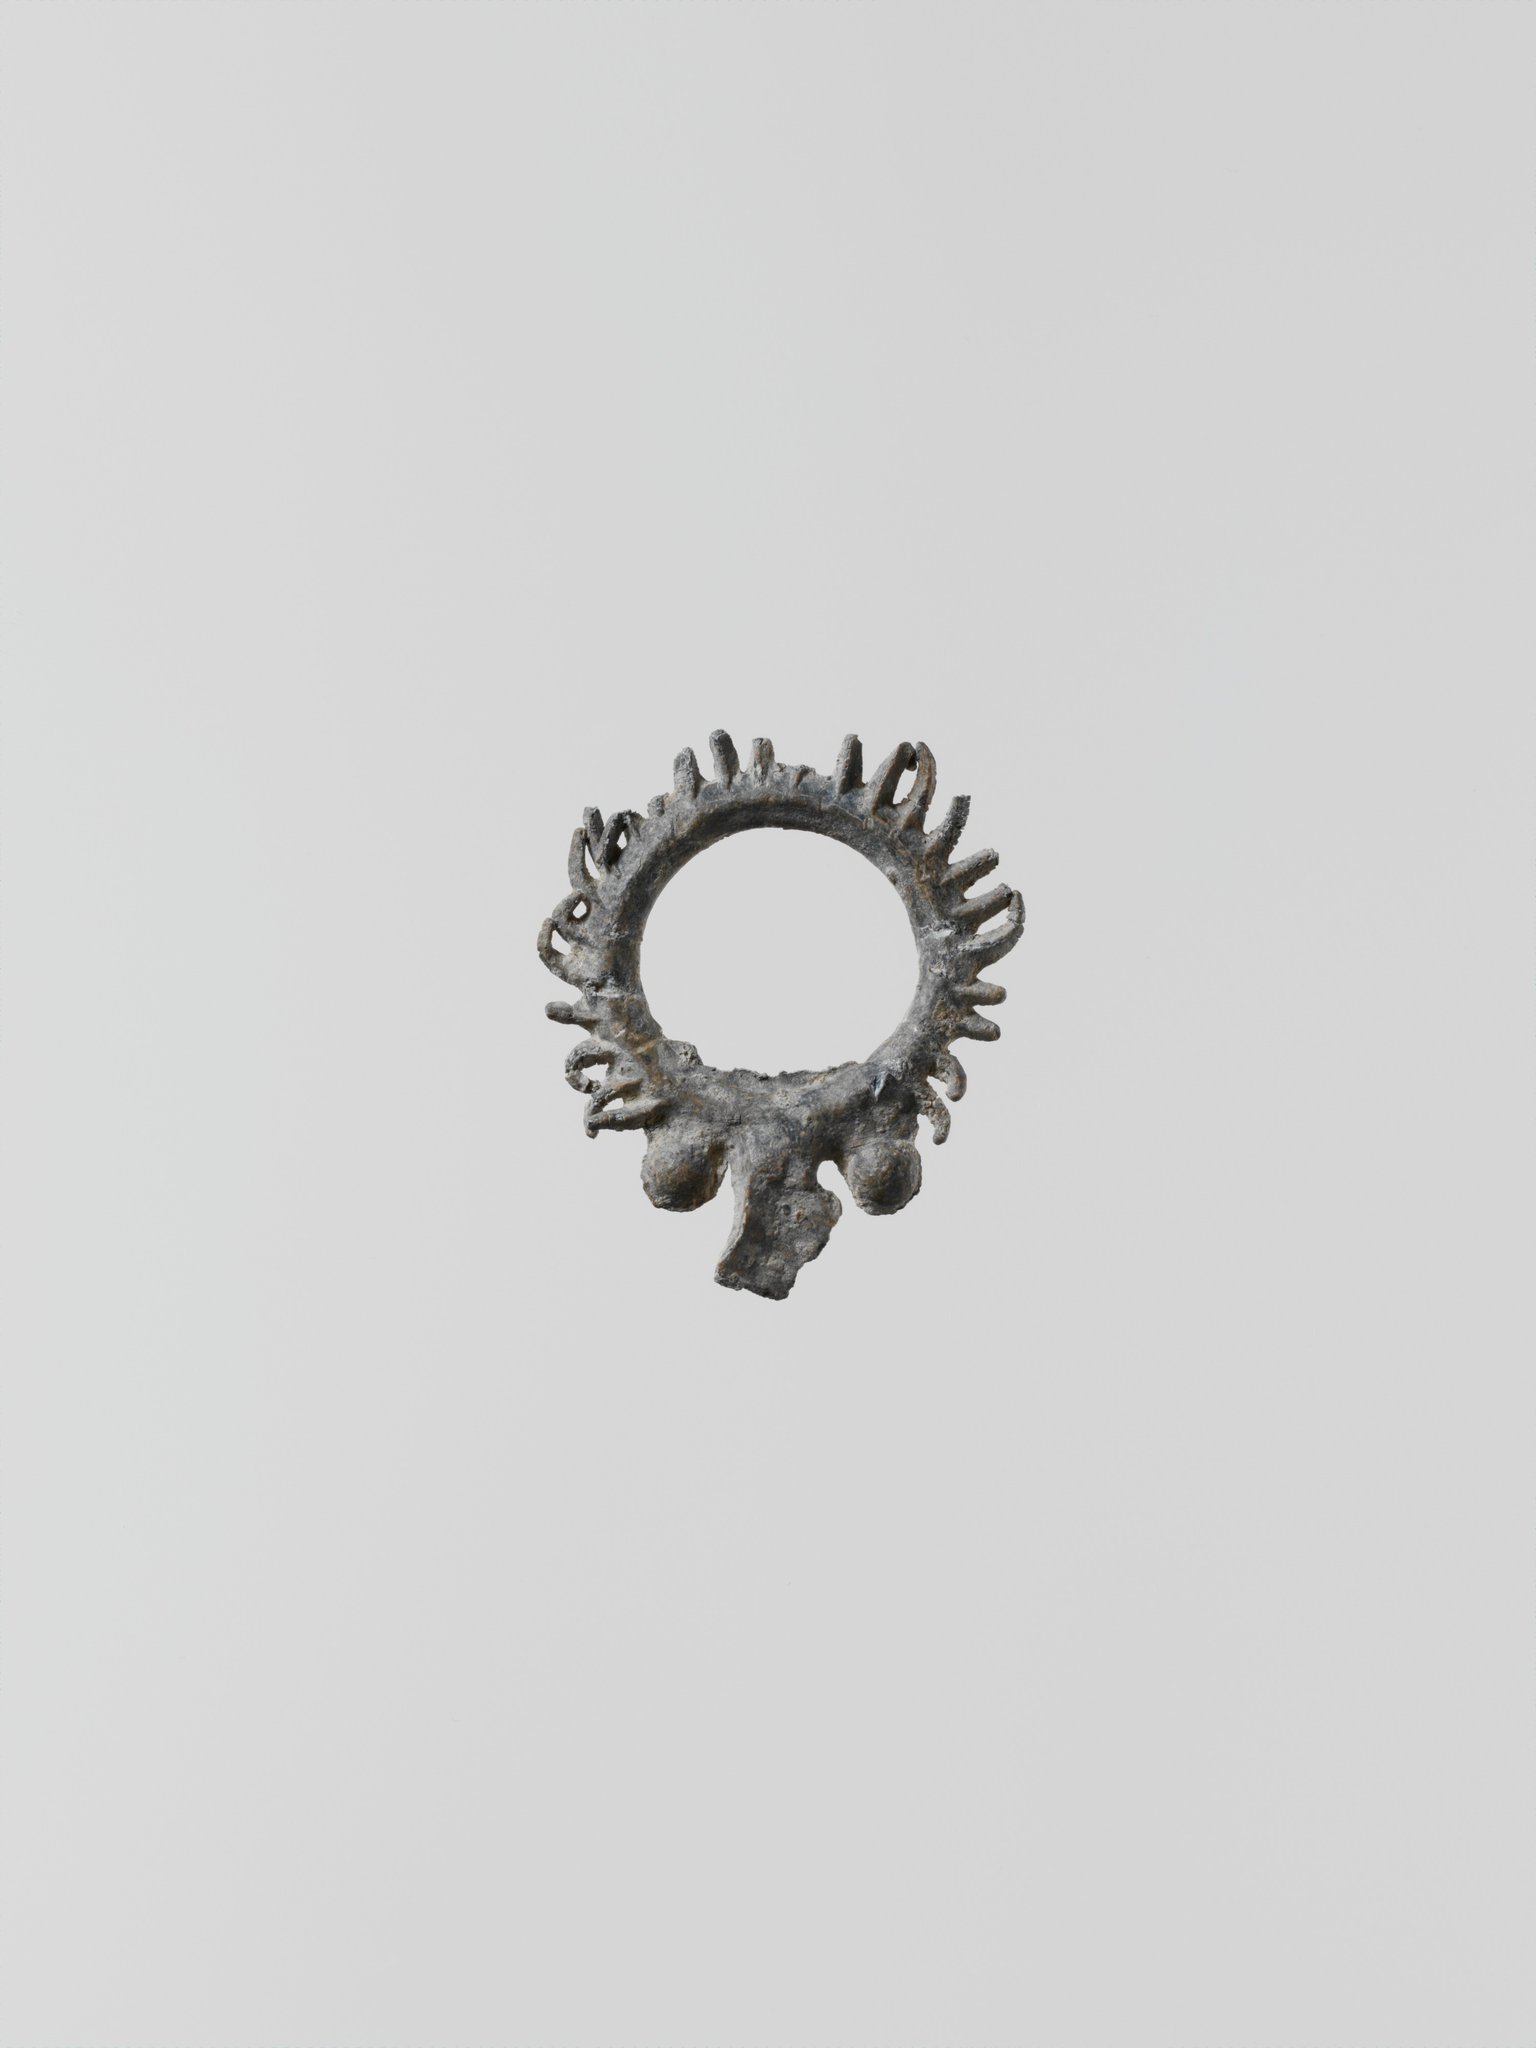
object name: wreath, 11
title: Wreaths, 11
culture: greek, laconian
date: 7000-30 BCE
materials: lead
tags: wreaths